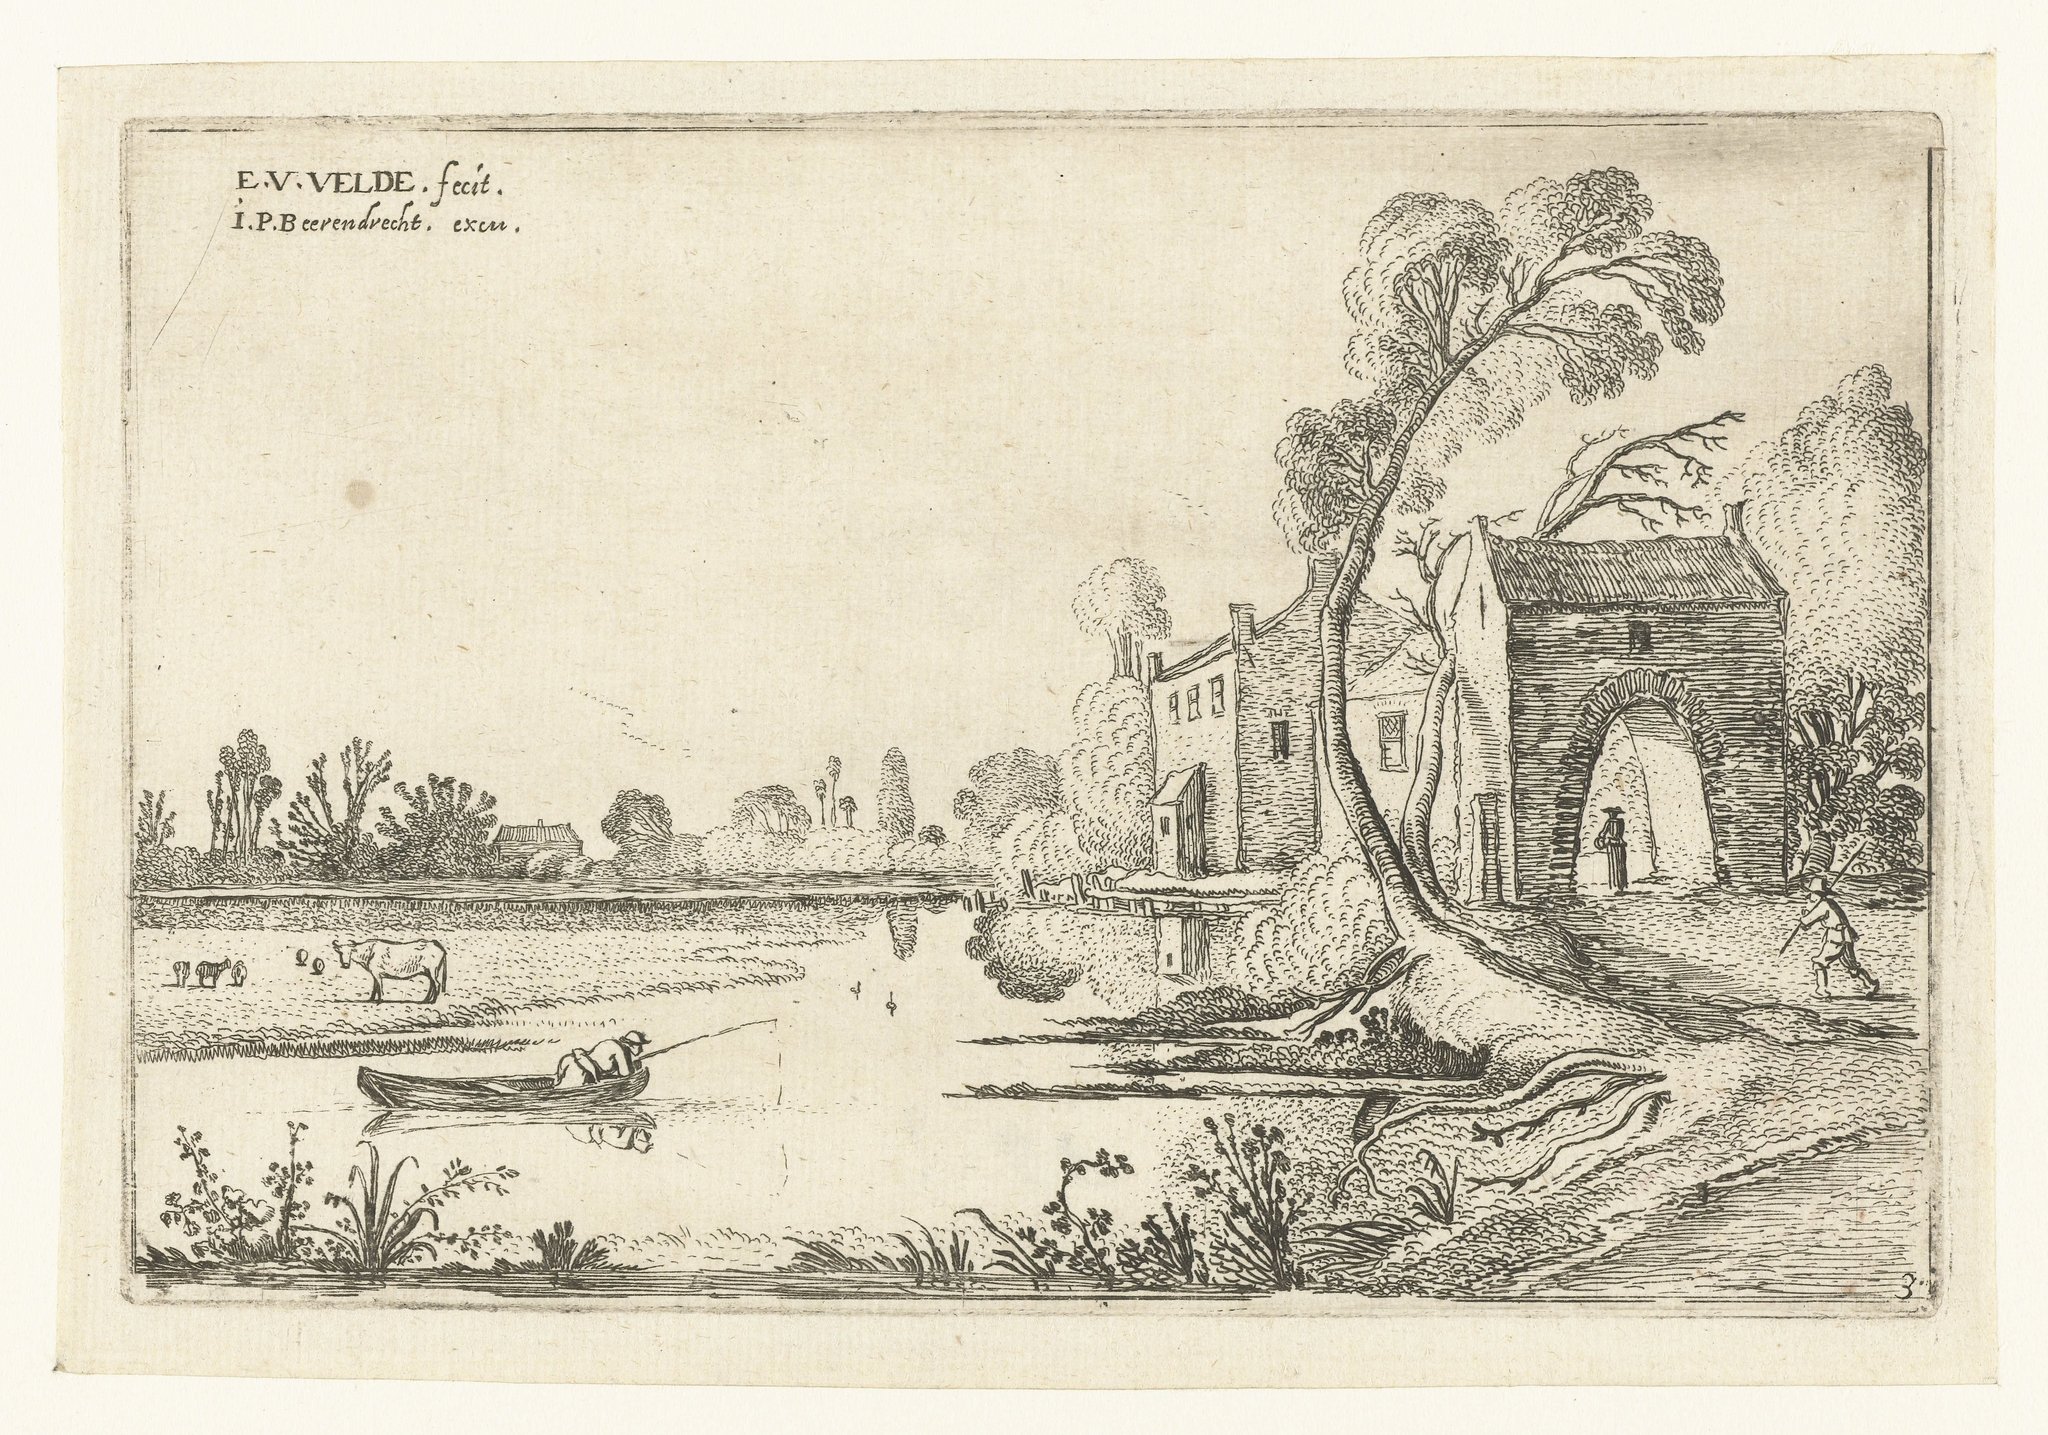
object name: print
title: Landschap met een rivier en poortgebouw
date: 1616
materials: paper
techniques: etching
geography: haarlem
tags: river, gate, entrance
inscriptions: collector's mark: Lugt 240